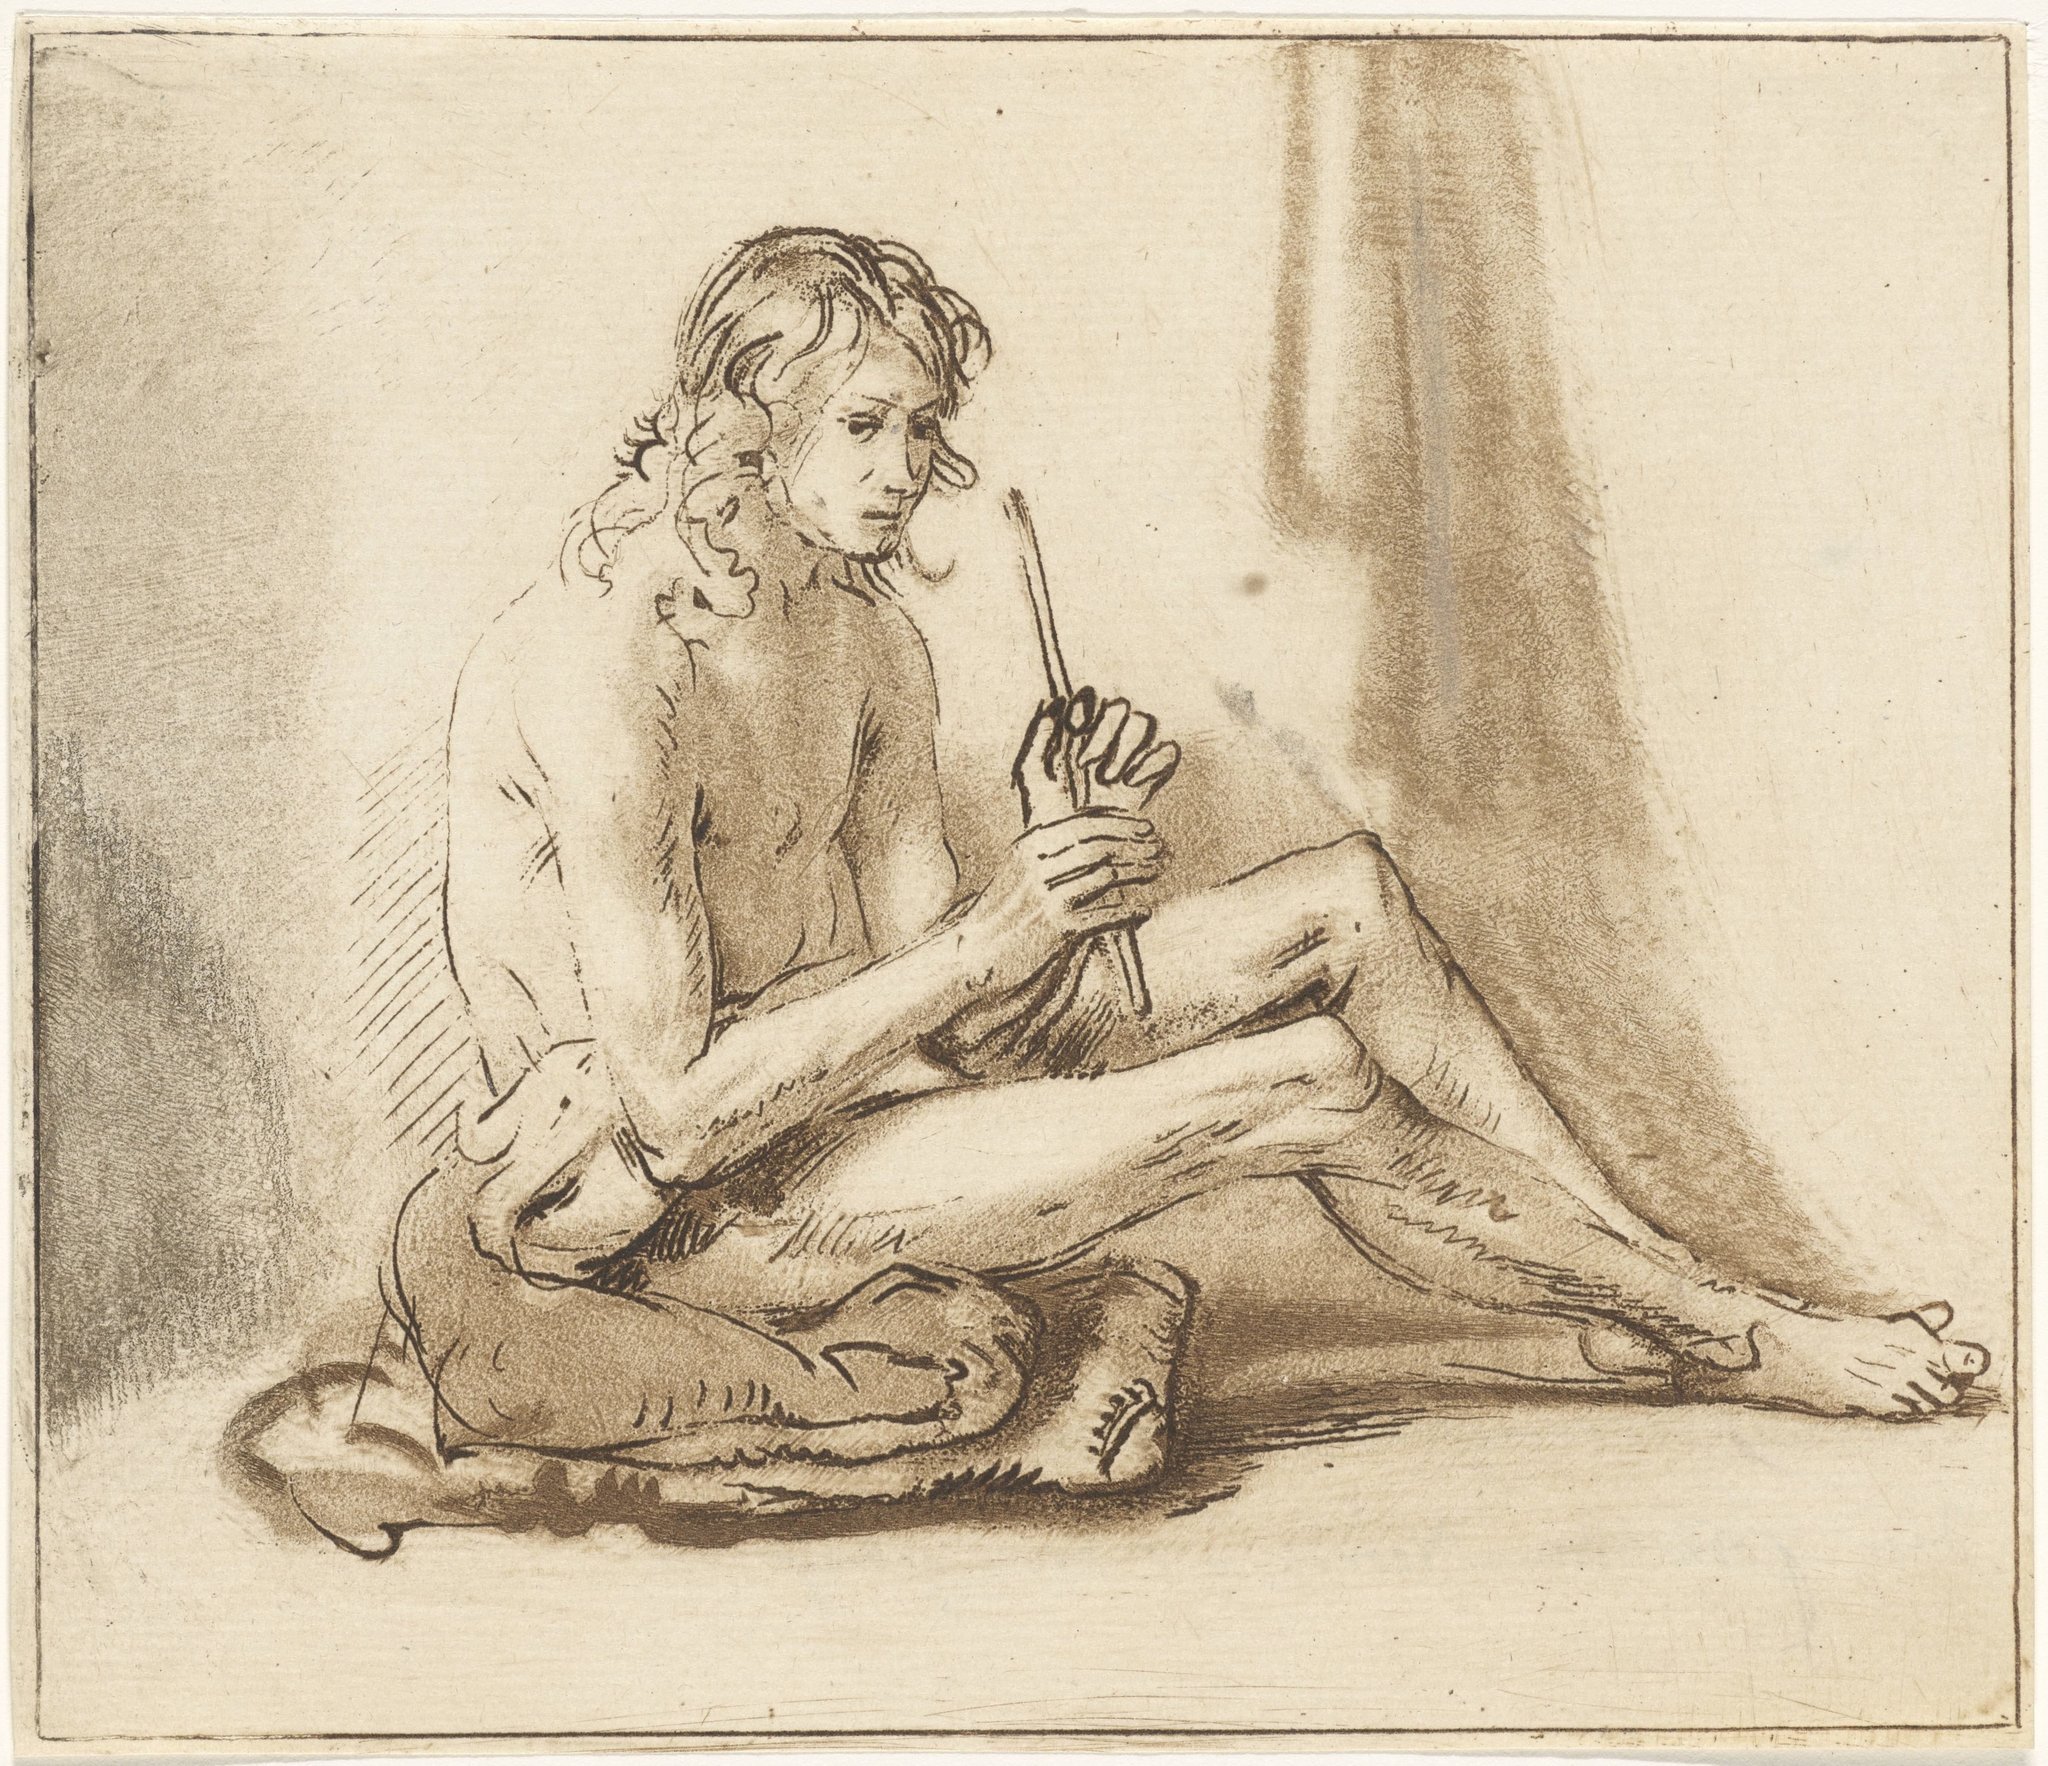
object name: print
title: Zittende naakte man met fluit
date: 1765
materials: paper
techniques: printing, printmaking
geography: haarlem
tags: wind instruments, sitting on the ground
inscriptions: collector's mark: Lugt 240, inscription: ‘na een Tekening van Rembrant door Corn : van Noorde in 't koper gebragt 1765’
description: Een naakte zittende man met een fluit of een stok in zijn handen.